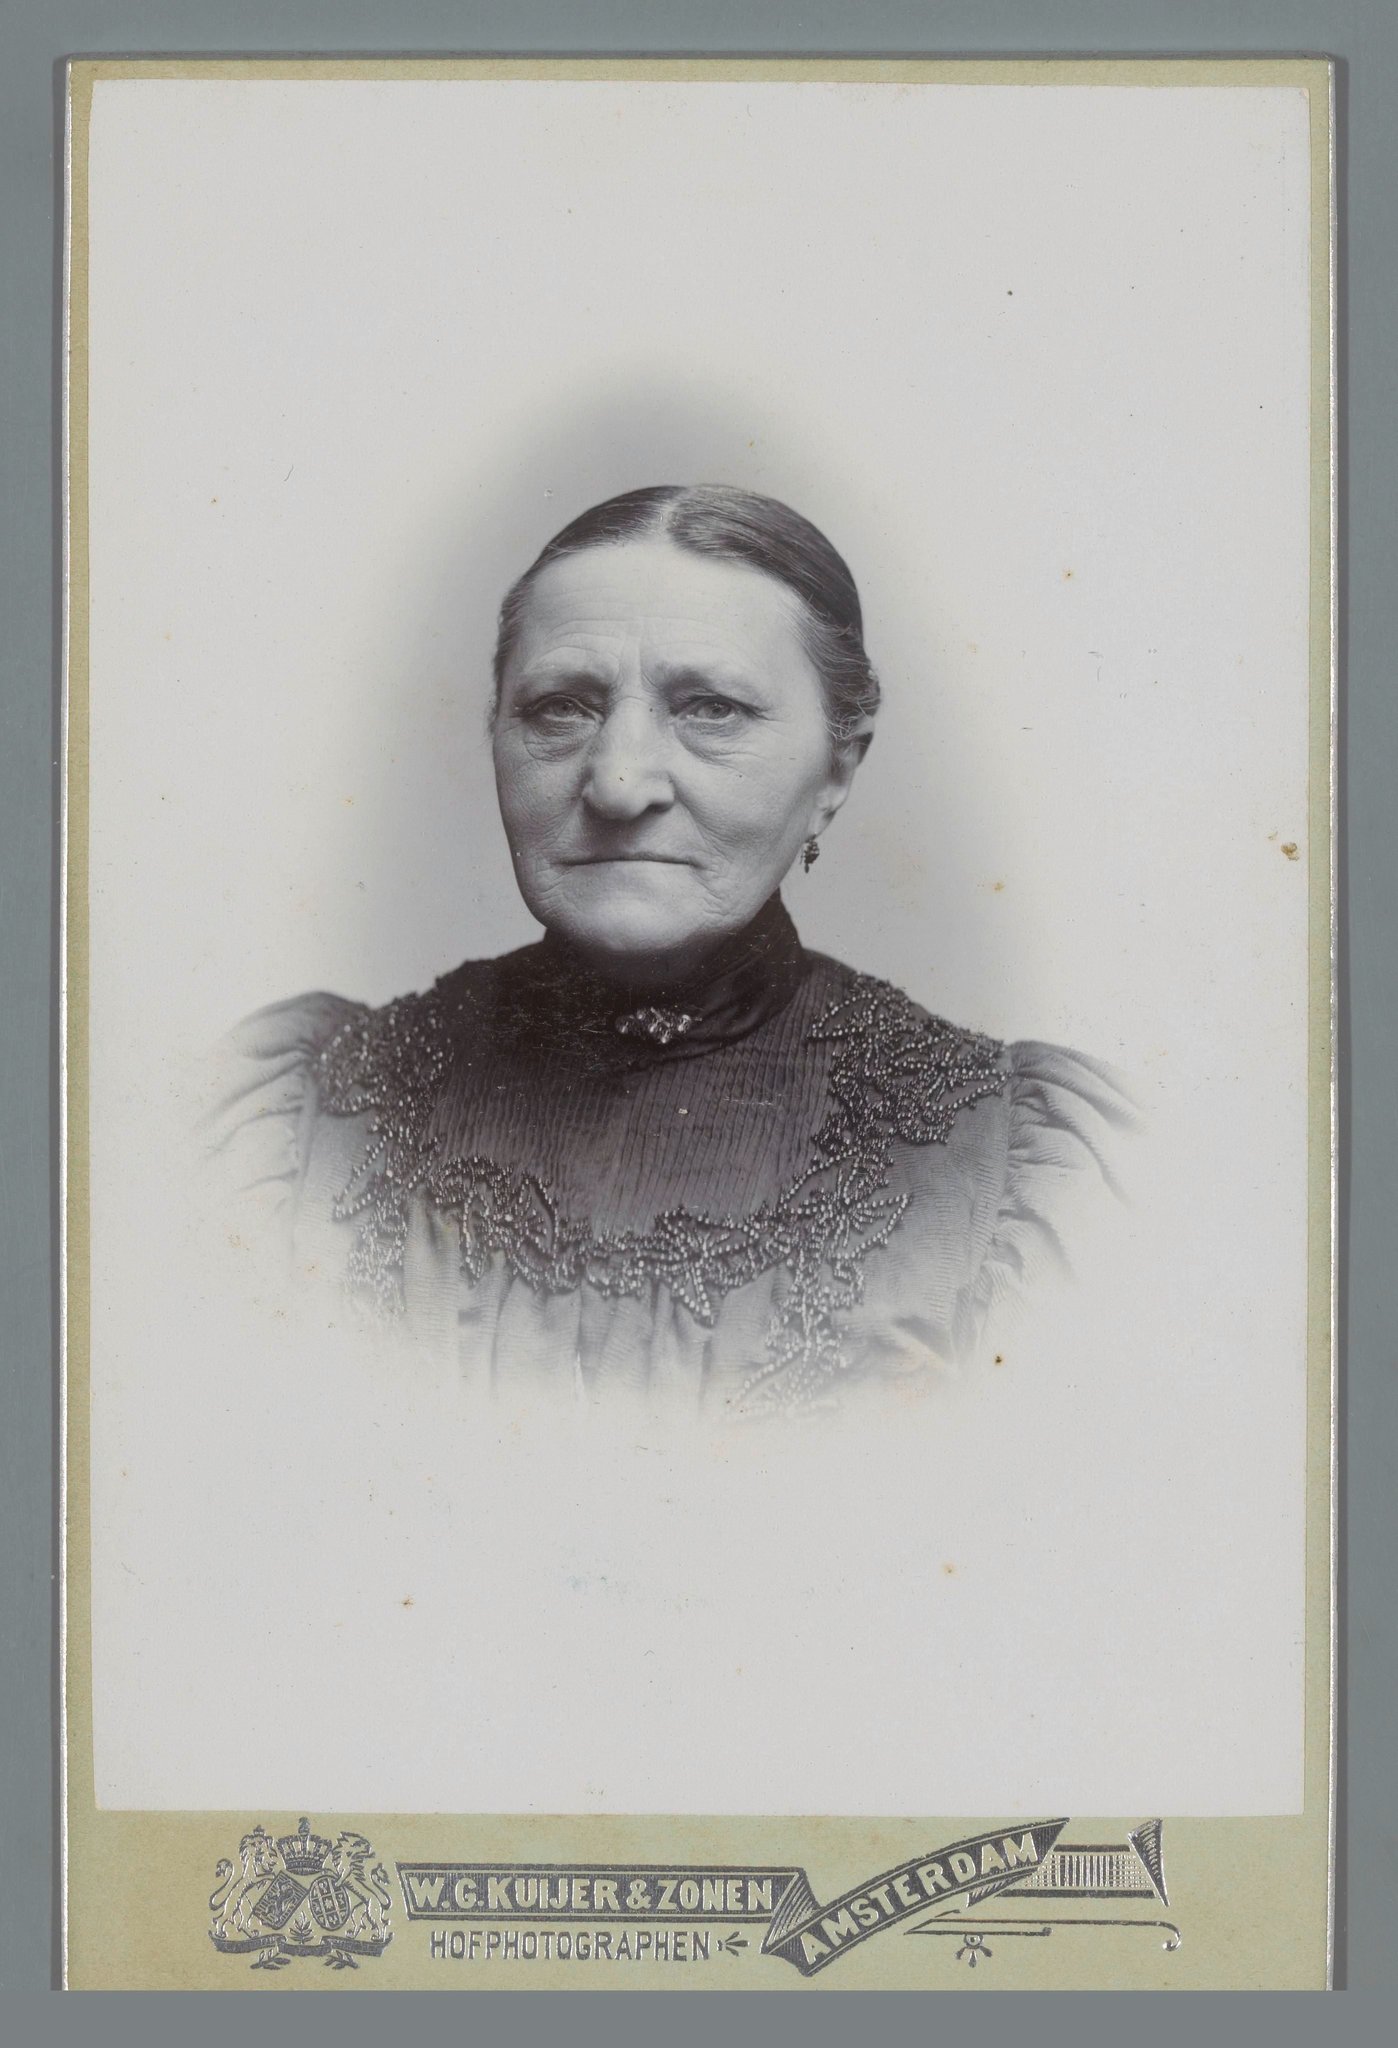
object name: cabinet photograph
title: Portret van een onbekende vrouw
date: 1885-1906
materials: cardboard, photographic support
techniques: collodion silver print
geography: amsterdam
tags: adult woman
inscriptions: name: ‘Opgericht 1864. W.G. Kuijer & Zonen Hofphotographen Westermarkt 19. Amsterdam (...)’